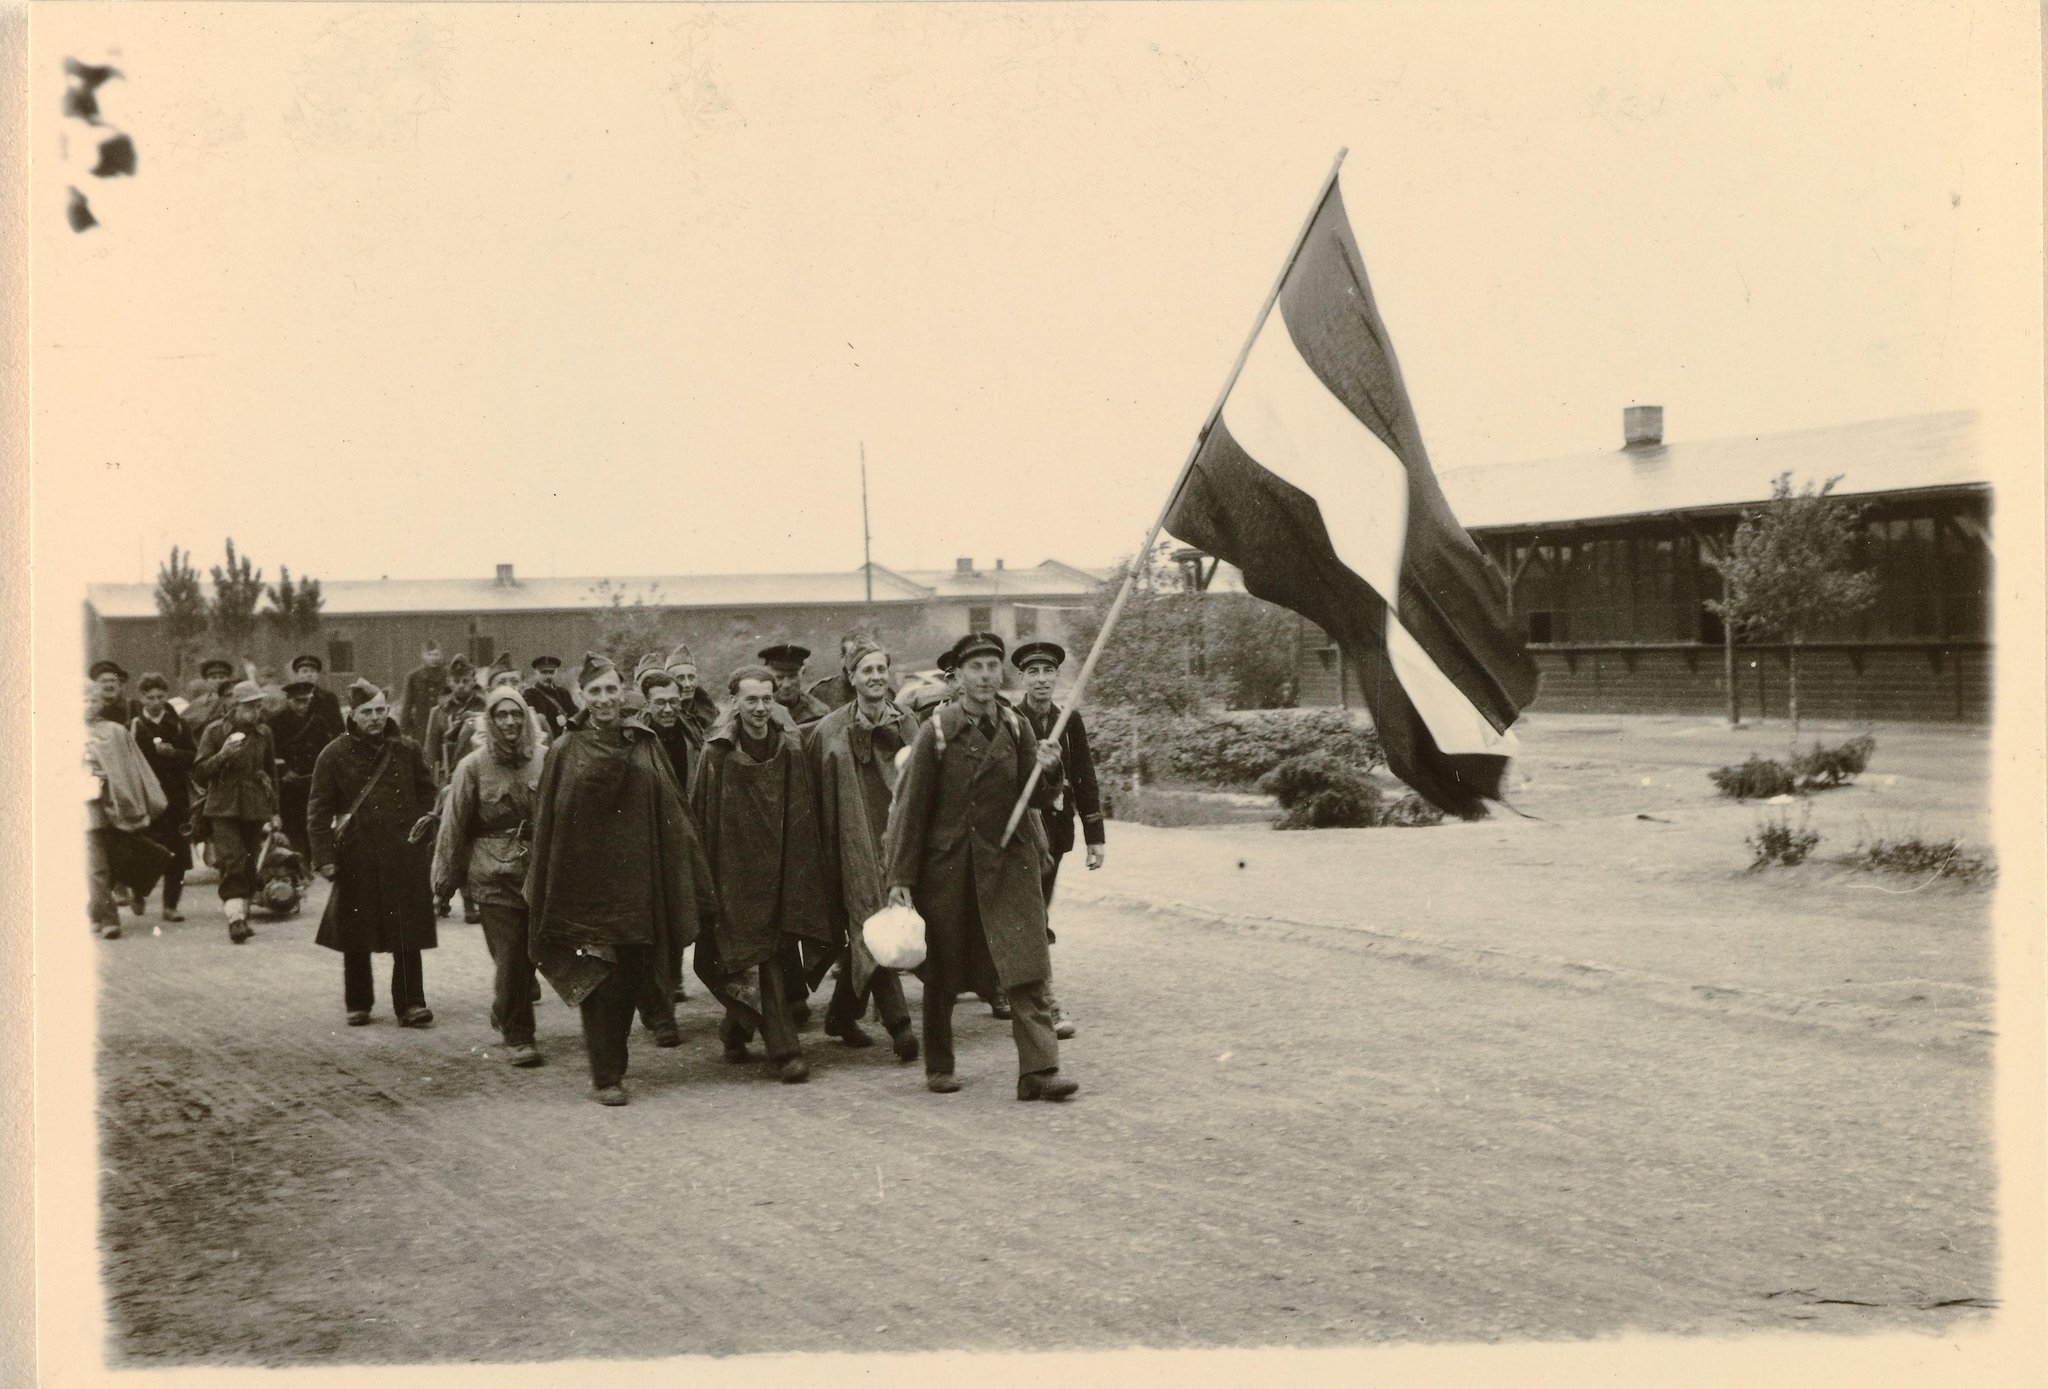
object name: photograph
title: Vertrek van de Nederlanders uit het kamp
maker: dick w.b. van maarseveen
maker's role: fotograaf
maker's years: 1905-1990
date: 1945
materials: photographic support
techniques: gelatin silver print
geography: muhlberg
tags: the hague, dick w.b. van maarseveen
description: Vertrek van de Nederlanders uit het kamp, de Nederlandse vlag voorop, 1945. Onderdeel van een groep foto's gemaakt door Dick van Maarseveen in het Duitse krijgsgevangenenkamp Stalag IV B in Mühlberg in de periode 1943-1945.